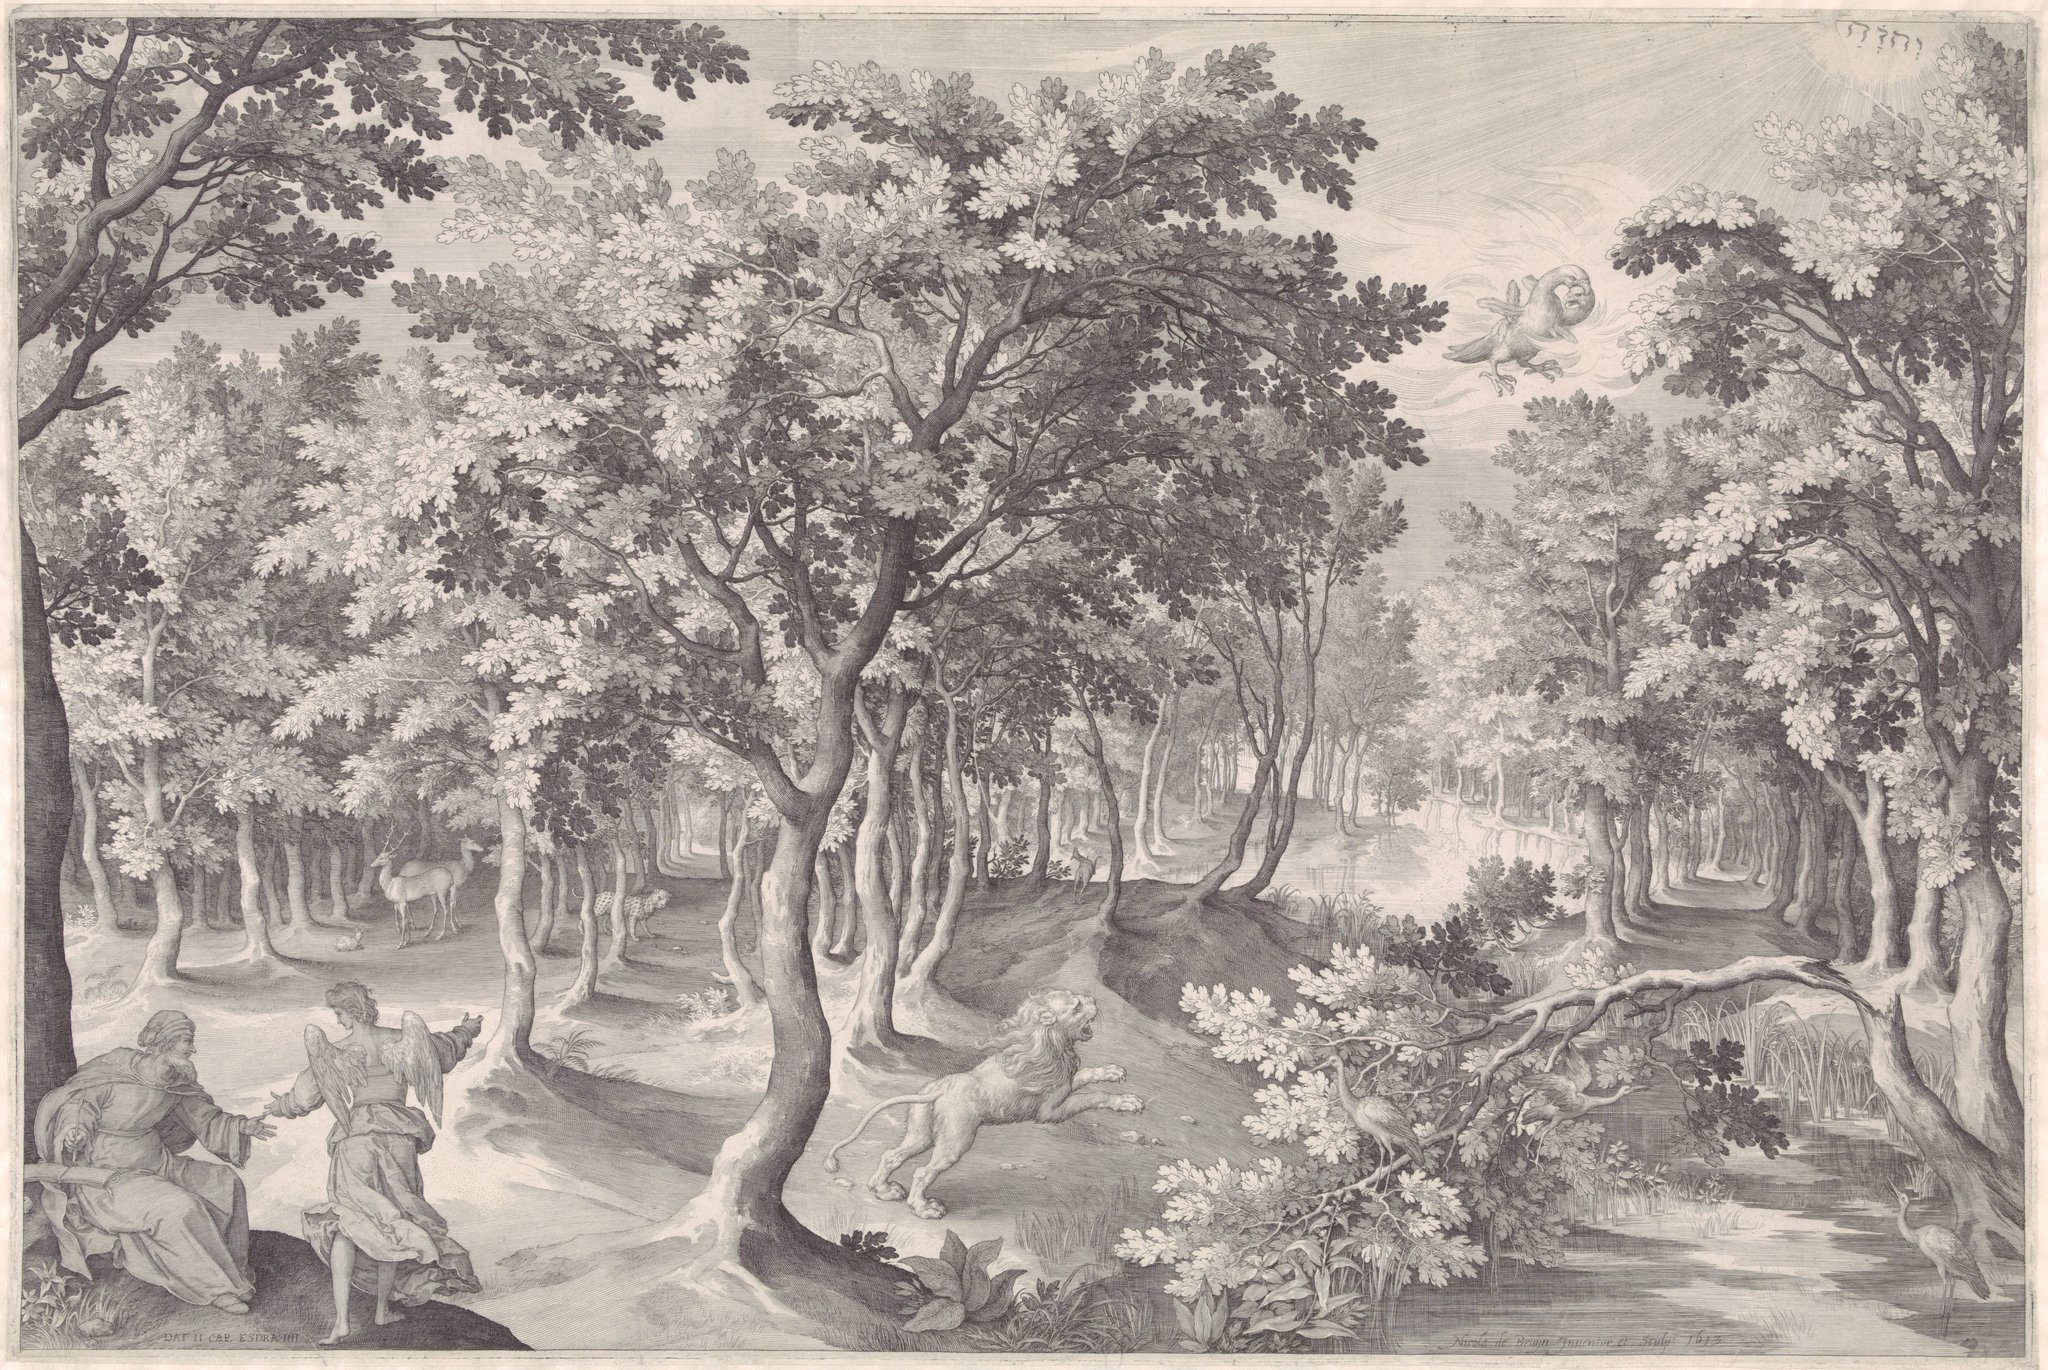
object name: print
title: Vijfde visioen van Ezra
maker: nicolaes de bruyn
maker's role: print maker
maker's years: 1571-1656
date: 1613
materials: paper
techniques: engraving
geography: antwerp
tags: ezra's vision of the eagle and the lion (2 esdras 11-12) (+ god the father in the form of light), ezra's vision of the eagle and the lion (2 esdras 11-12) (+ angel(s)), tetragram (in roman or hebrew script) ~ symbol of god the father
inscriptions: collector's mark: Lugt 2228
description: Het vijfde visioen van Ezra. In een bos brult een leeuw naar de hemel, waar een brandende adelaar met drie hoofden zichzelf verslindt. Links op de voorgrond verklaart een engel het visioen aan de profeet Ezra (2 Ezra). In de rechterbovenhoek het tetragram als symbool voor God de Vader.